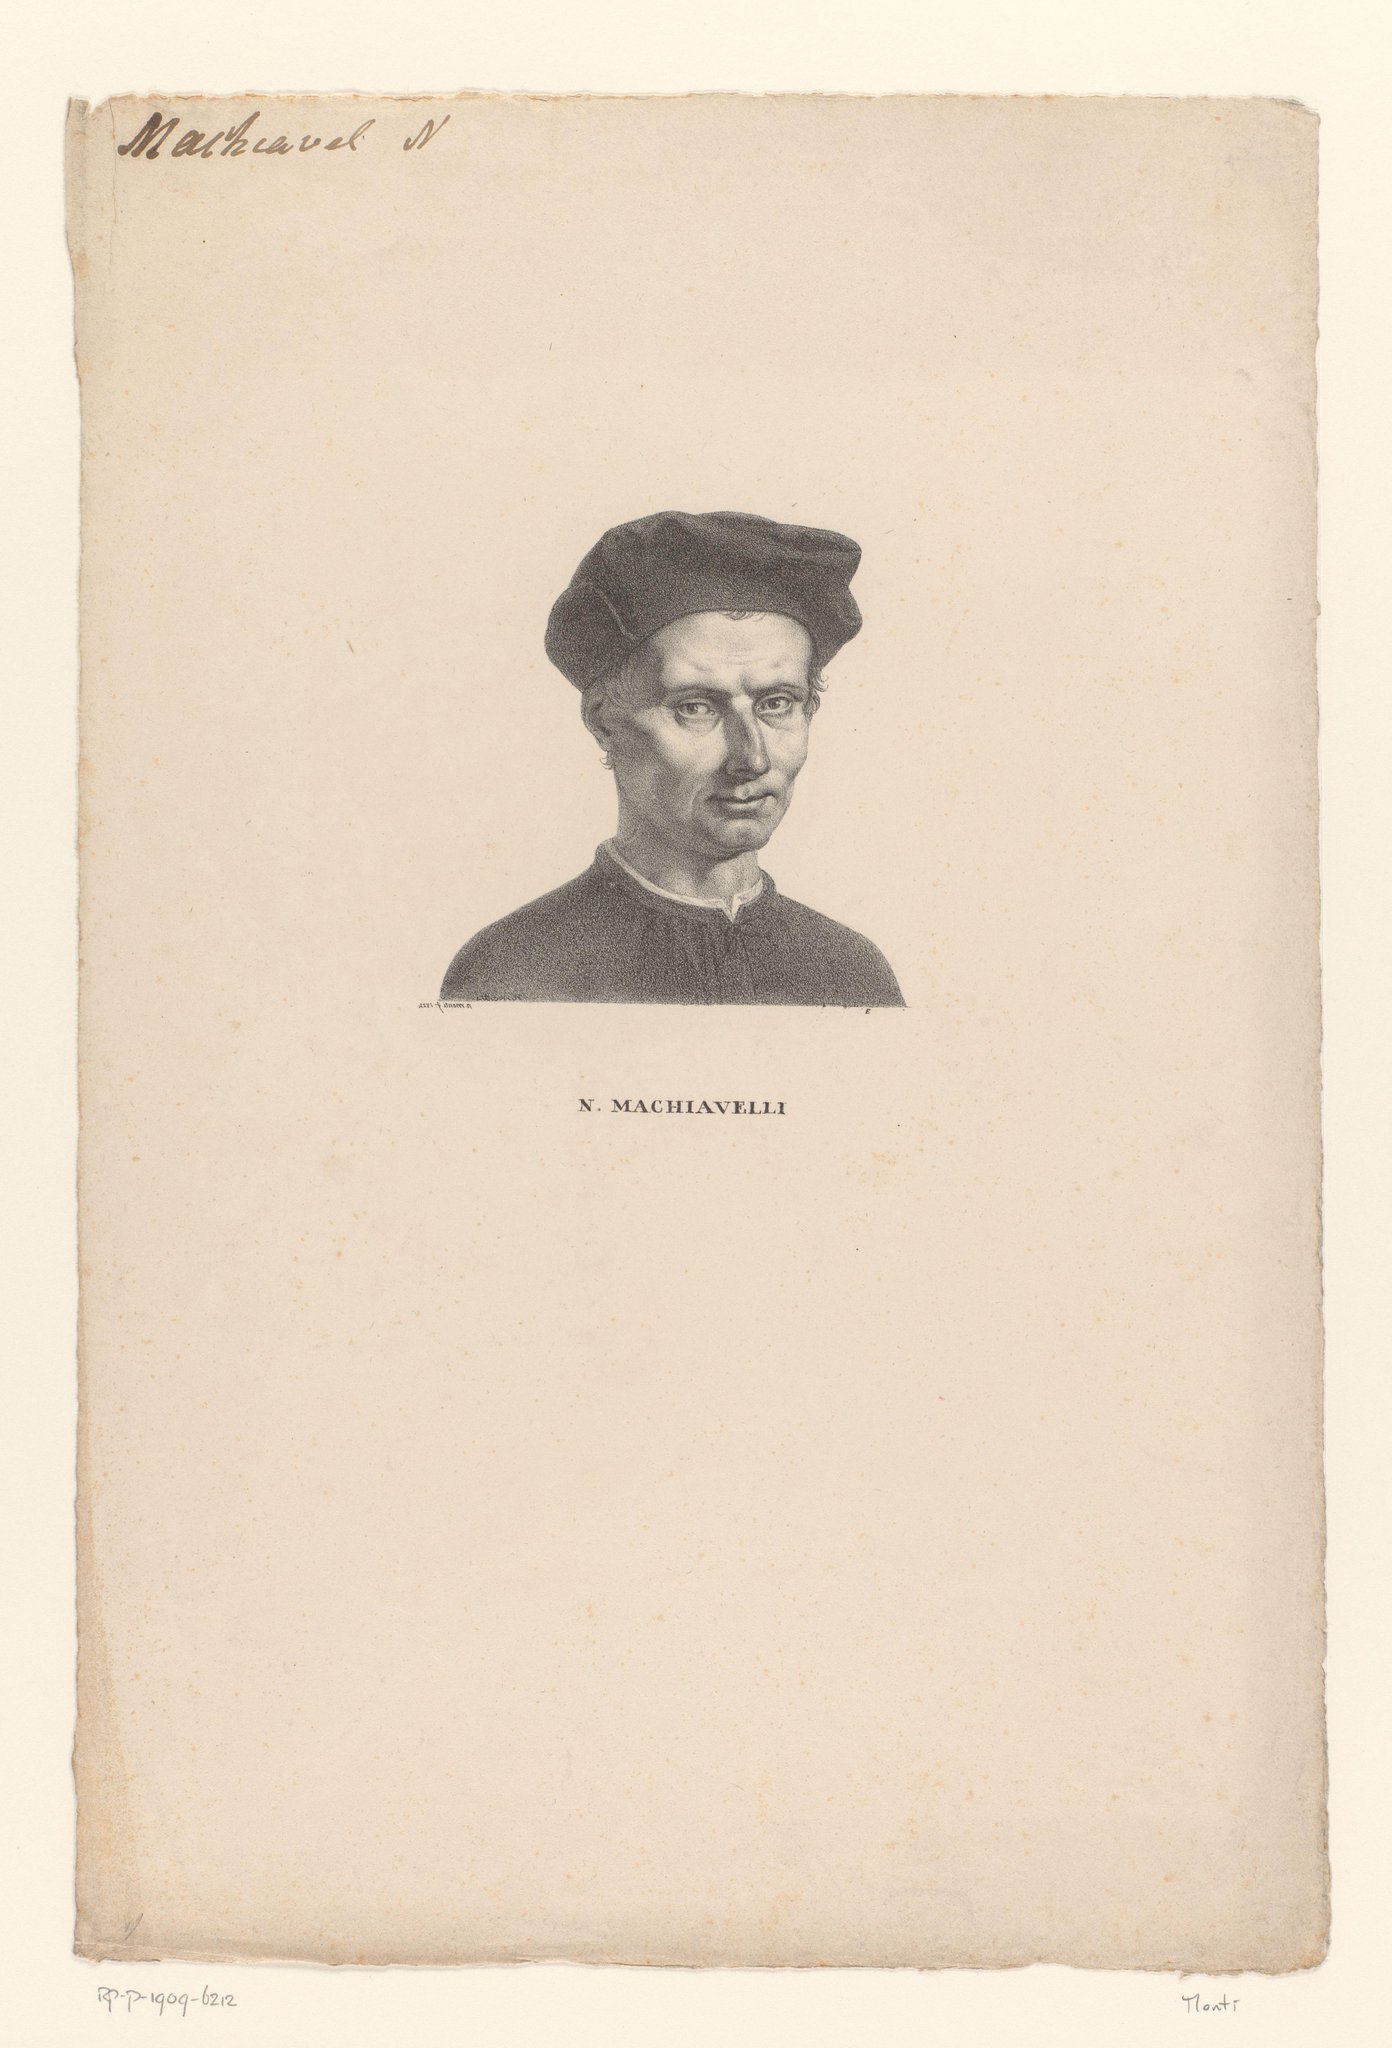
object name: print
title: Portret van Niccolò Machiavelli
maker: monti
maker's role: print maker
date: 1822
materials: paper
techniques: lithograph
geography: italy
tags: politician, historical persons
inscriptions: collector's mark: Lugt 2228